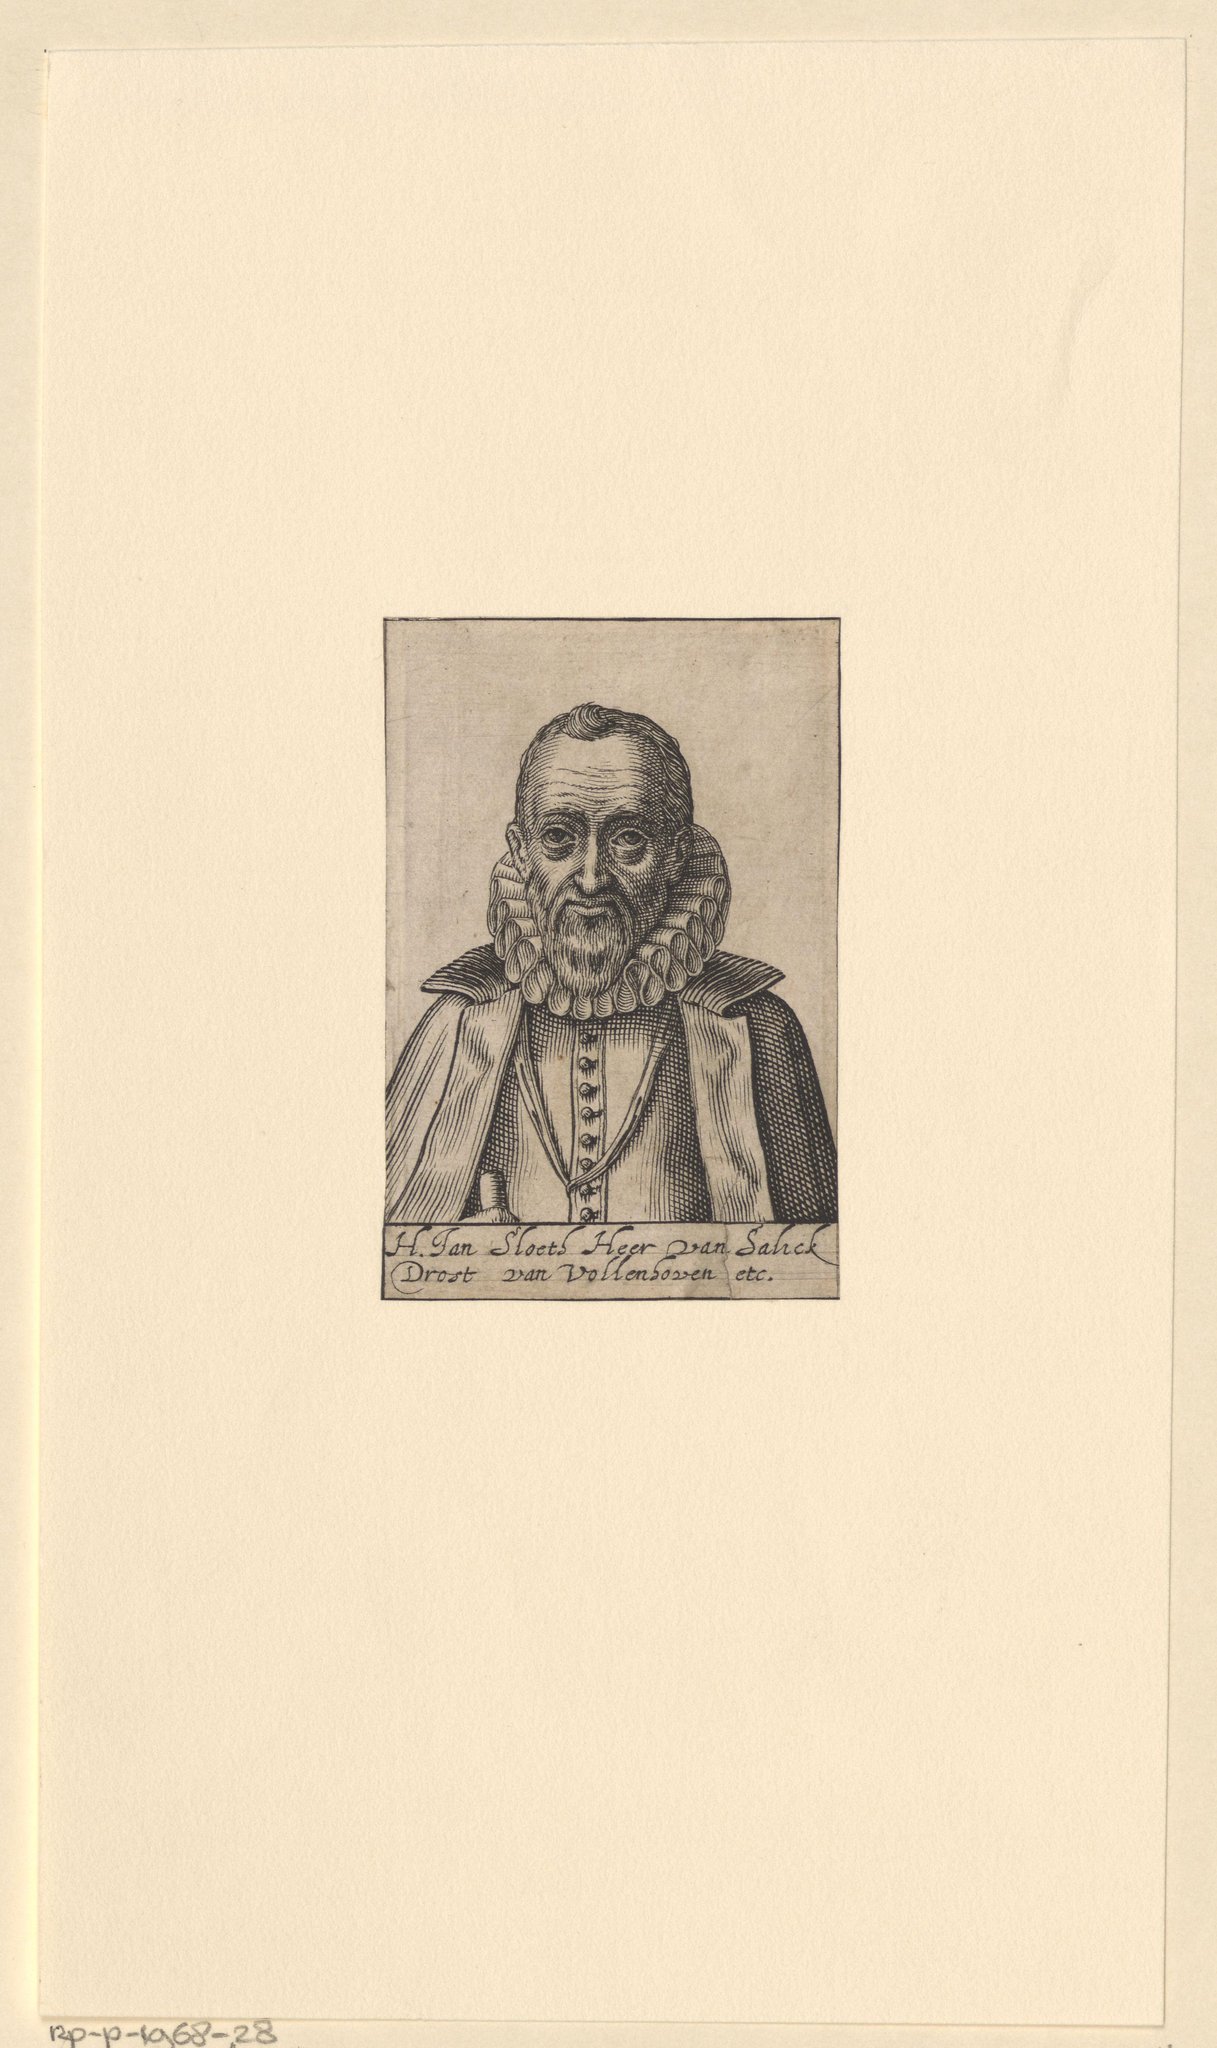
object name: print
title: Portret van Jan Sloet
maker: Anonymous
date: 1608-1699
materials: paper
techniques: engraving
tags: governmental and representative bodies, historical persons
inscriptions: collector's mark: Lugt 2760, collector's mark: Lugt 2228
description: Onderdeel van een blad met de portretten van de achttien deelnemers bij de vredesonderhandelingen tussen de Republiek en Spanje te Den Haag, februari 1608.